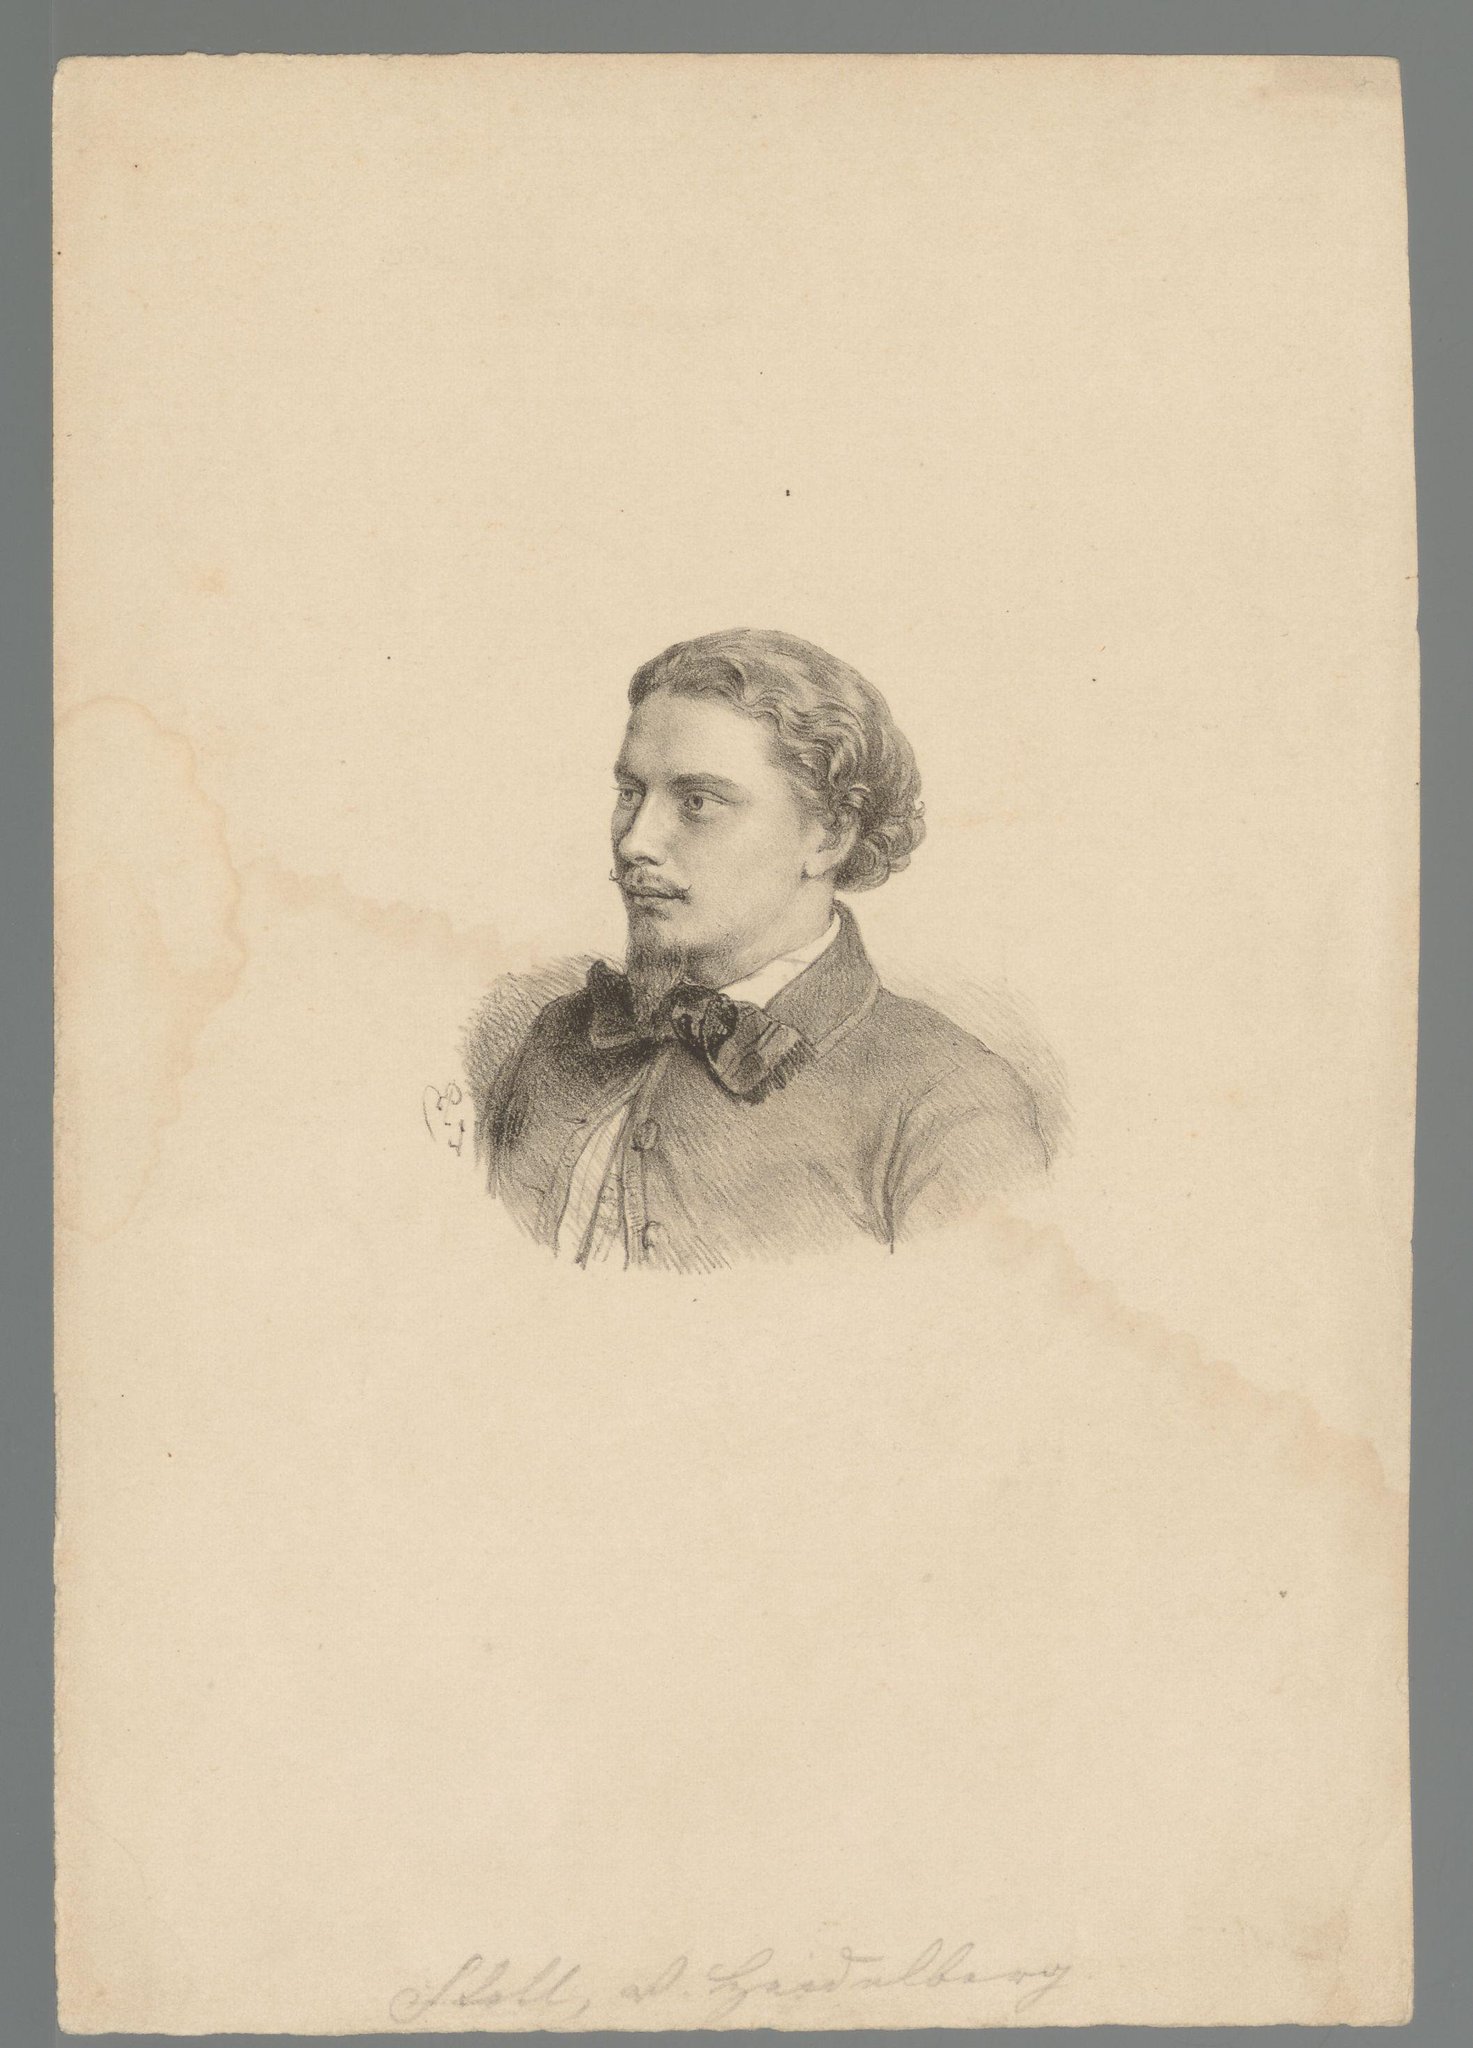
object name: print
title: Portret van een onbekende man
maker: monogrammist lb (duitsland 19e eeuw)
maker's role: draughtsman, print maker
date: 1820-1870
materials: paper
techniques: lithograph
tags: adult man, historical persons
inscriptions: collector's mark: Lugt 2228